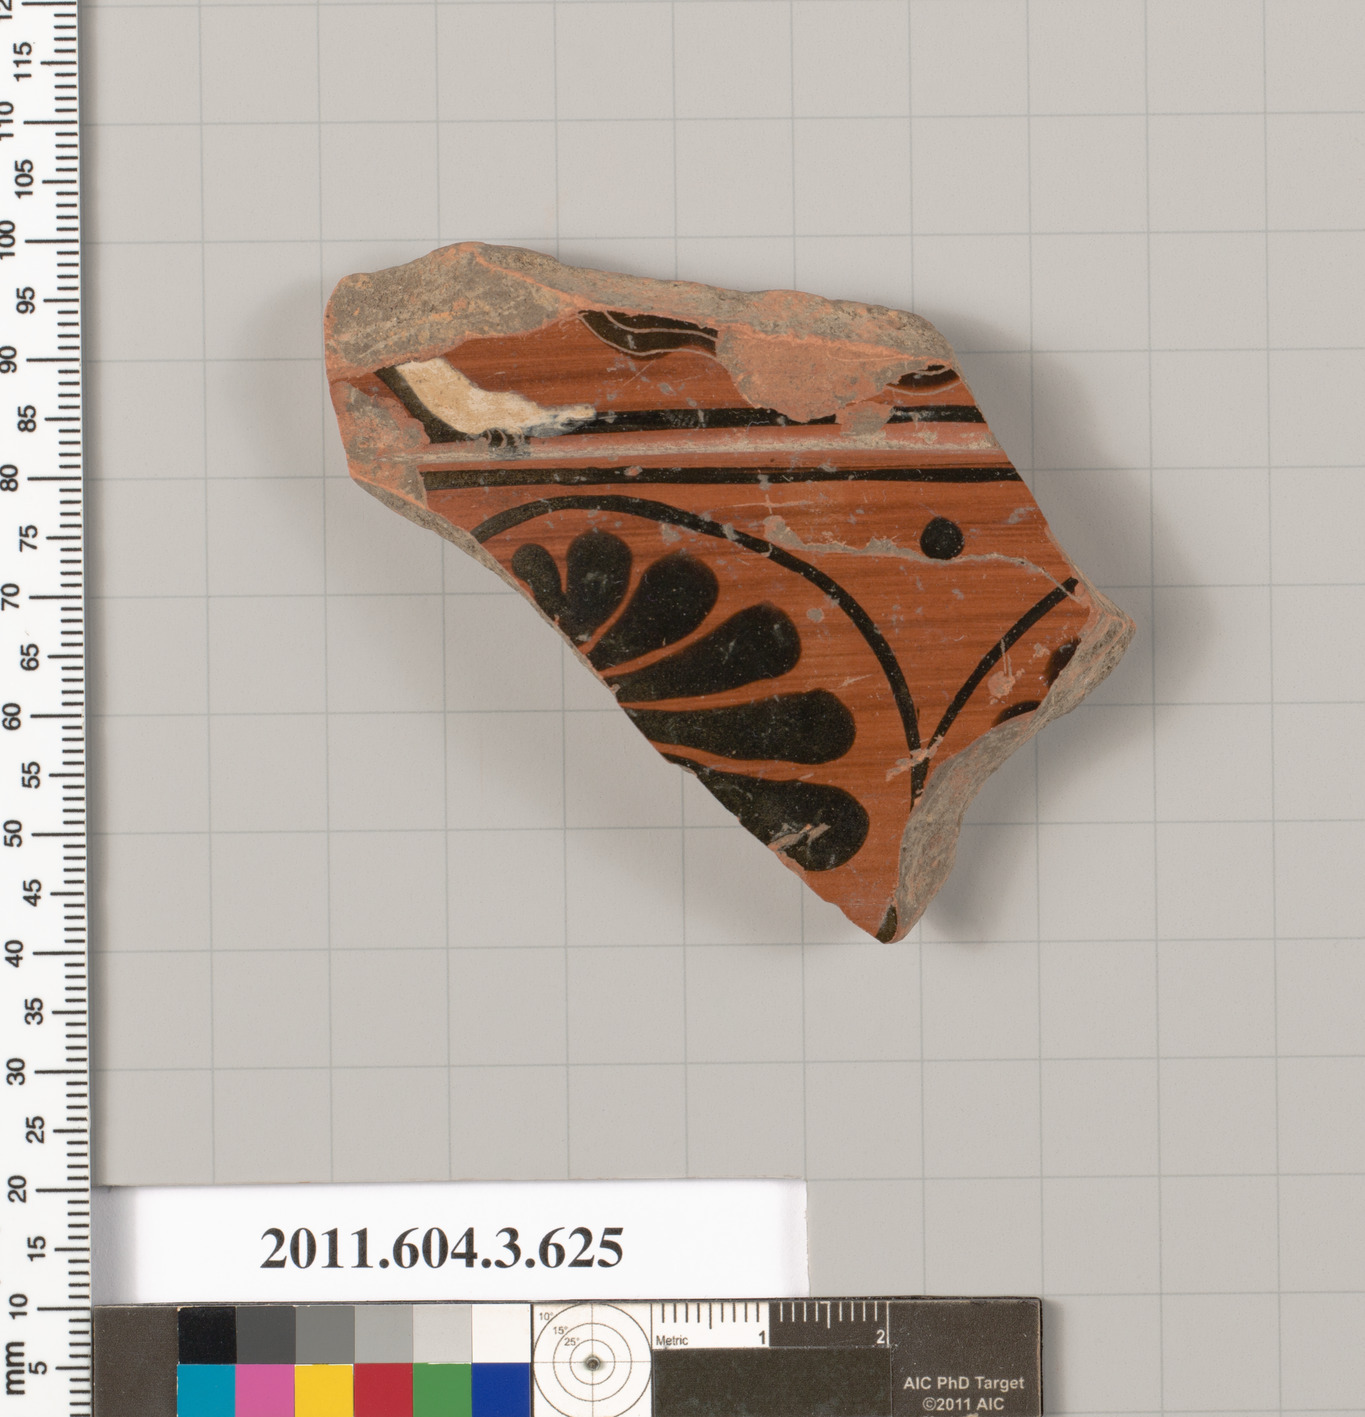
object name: calyx krater fragment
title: Terracotta fragment of a calyx-krater (bowl for mixing wine and water)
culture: greek, attic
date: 500-480 BCE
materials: terracotta